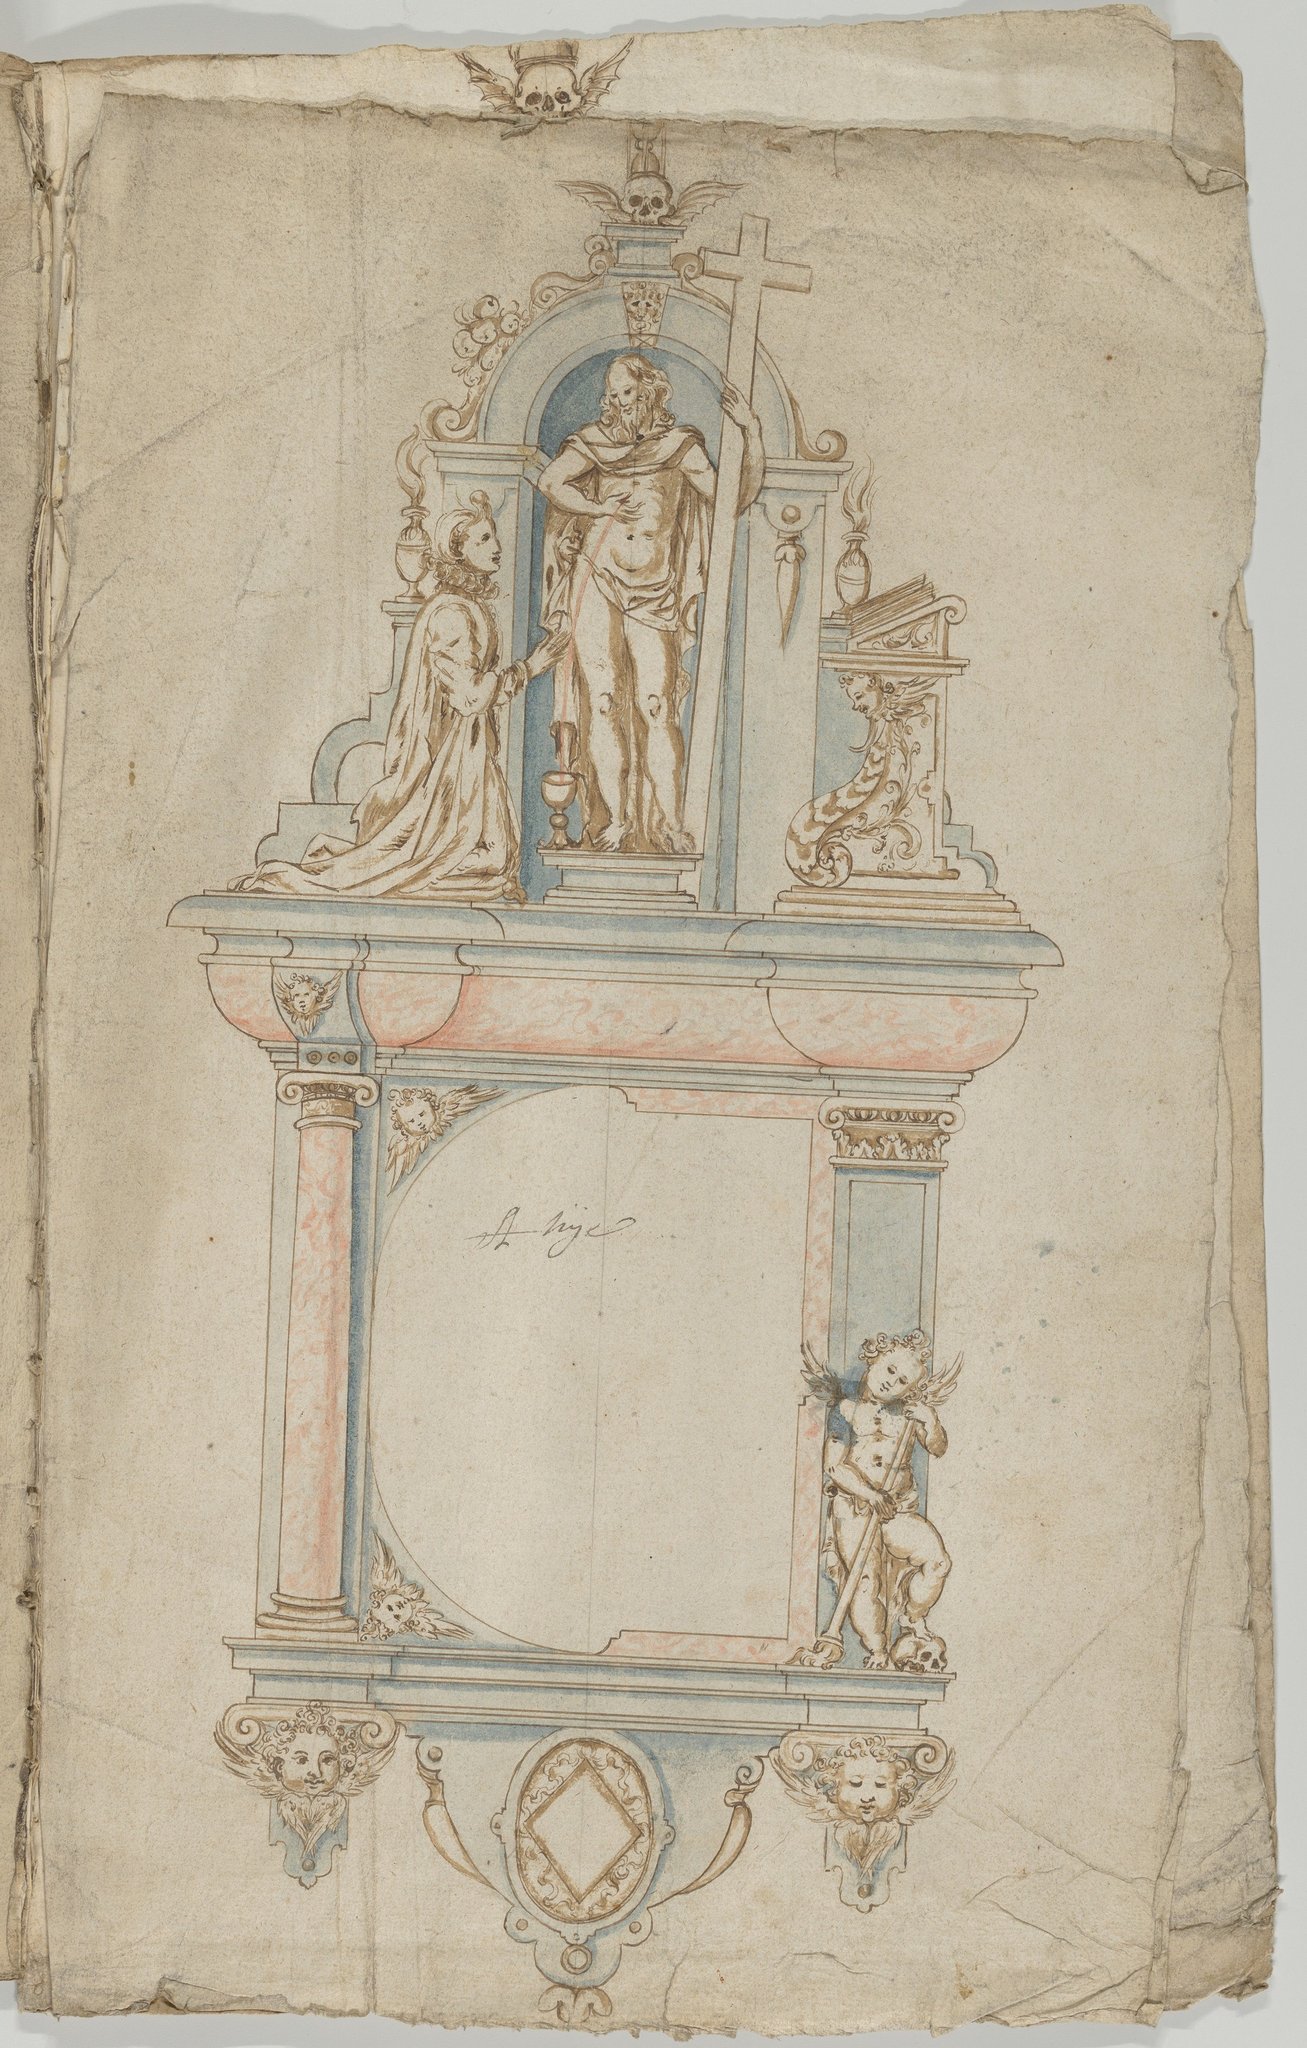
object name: drawing ornament architecture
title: Design for a Wall Tomb with a Variant and Statues of the Resurrected Christ and a kneeling Donor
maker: anonymous, flemish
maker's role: artist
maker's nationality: flemish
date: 1601-1700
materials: ink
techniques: pen, wash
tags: tombs,skulls,angels,christ,cross